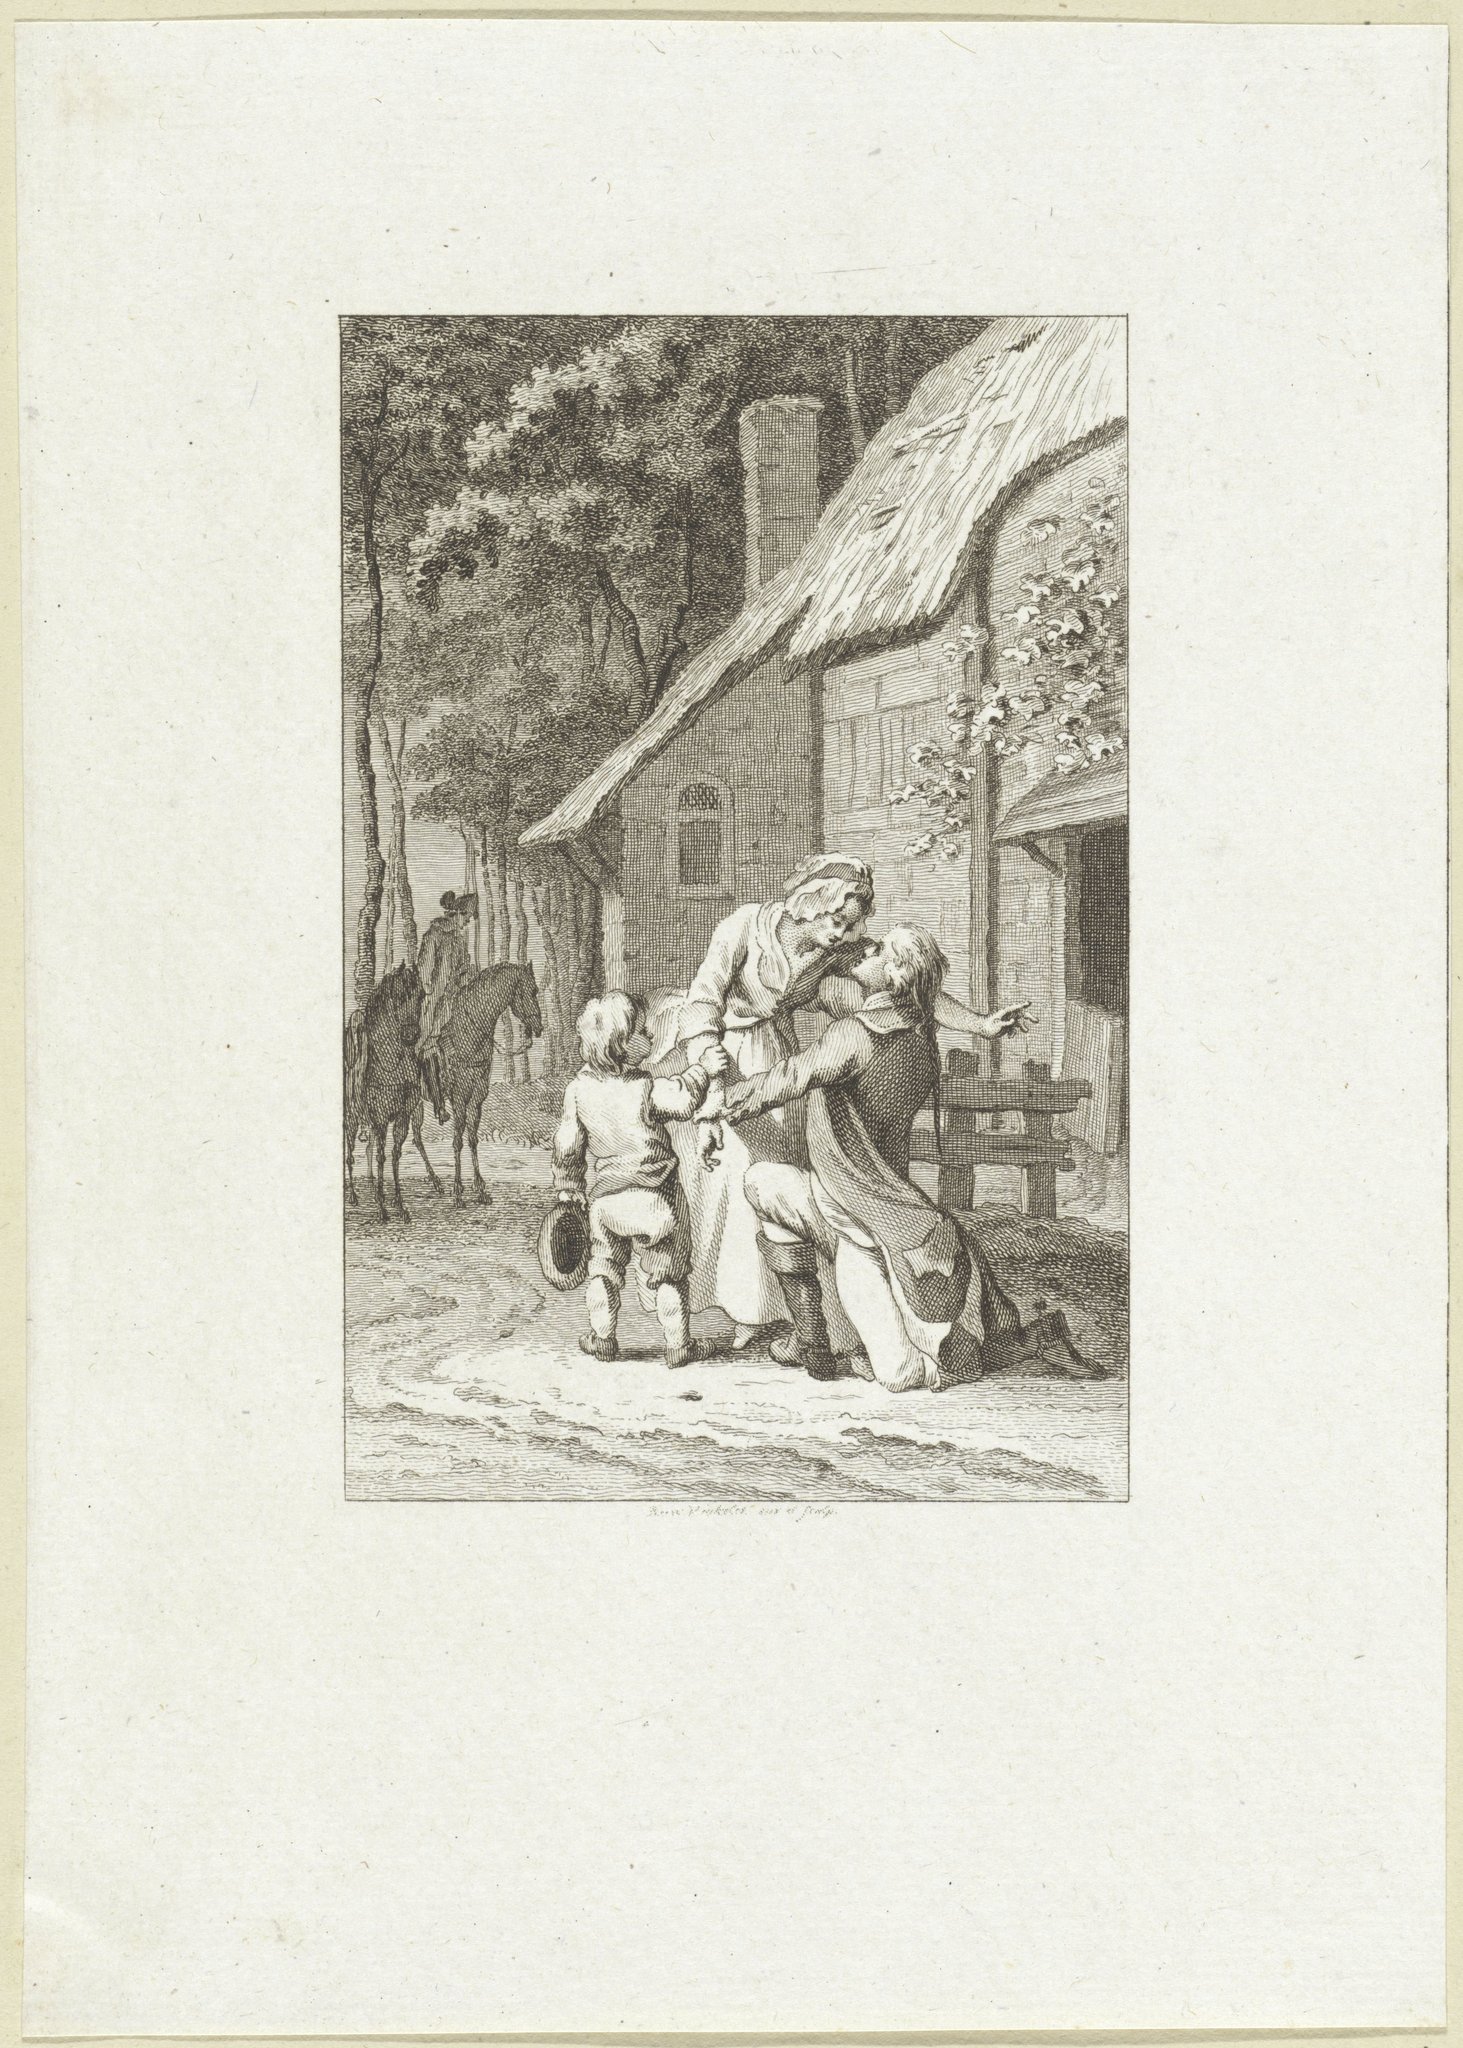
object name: print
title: Bosgezicht met een man die voor zijn geliefde knielt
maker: reinier vinkeles (i)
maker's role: draughtsman, print maker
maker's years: 1741-1816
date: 1788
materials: paper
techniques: engraving, etching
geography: amsterdam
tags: riding a horse, ass, or mule; rider, horseman, forest, wood, man kneeling before his beloved (proposing), plants and herbs: ivy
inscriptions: collector's mark: Lugt 240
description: Proefdruk van een prent die ook gebruikt is als illustratie bij het verhaal 'Fannij' voor: Baculard d'Arnaud, F.T.M. de. Zedelijke verhaalen, deel 11. Amsterdam: A. Mens Jansz., 1788.